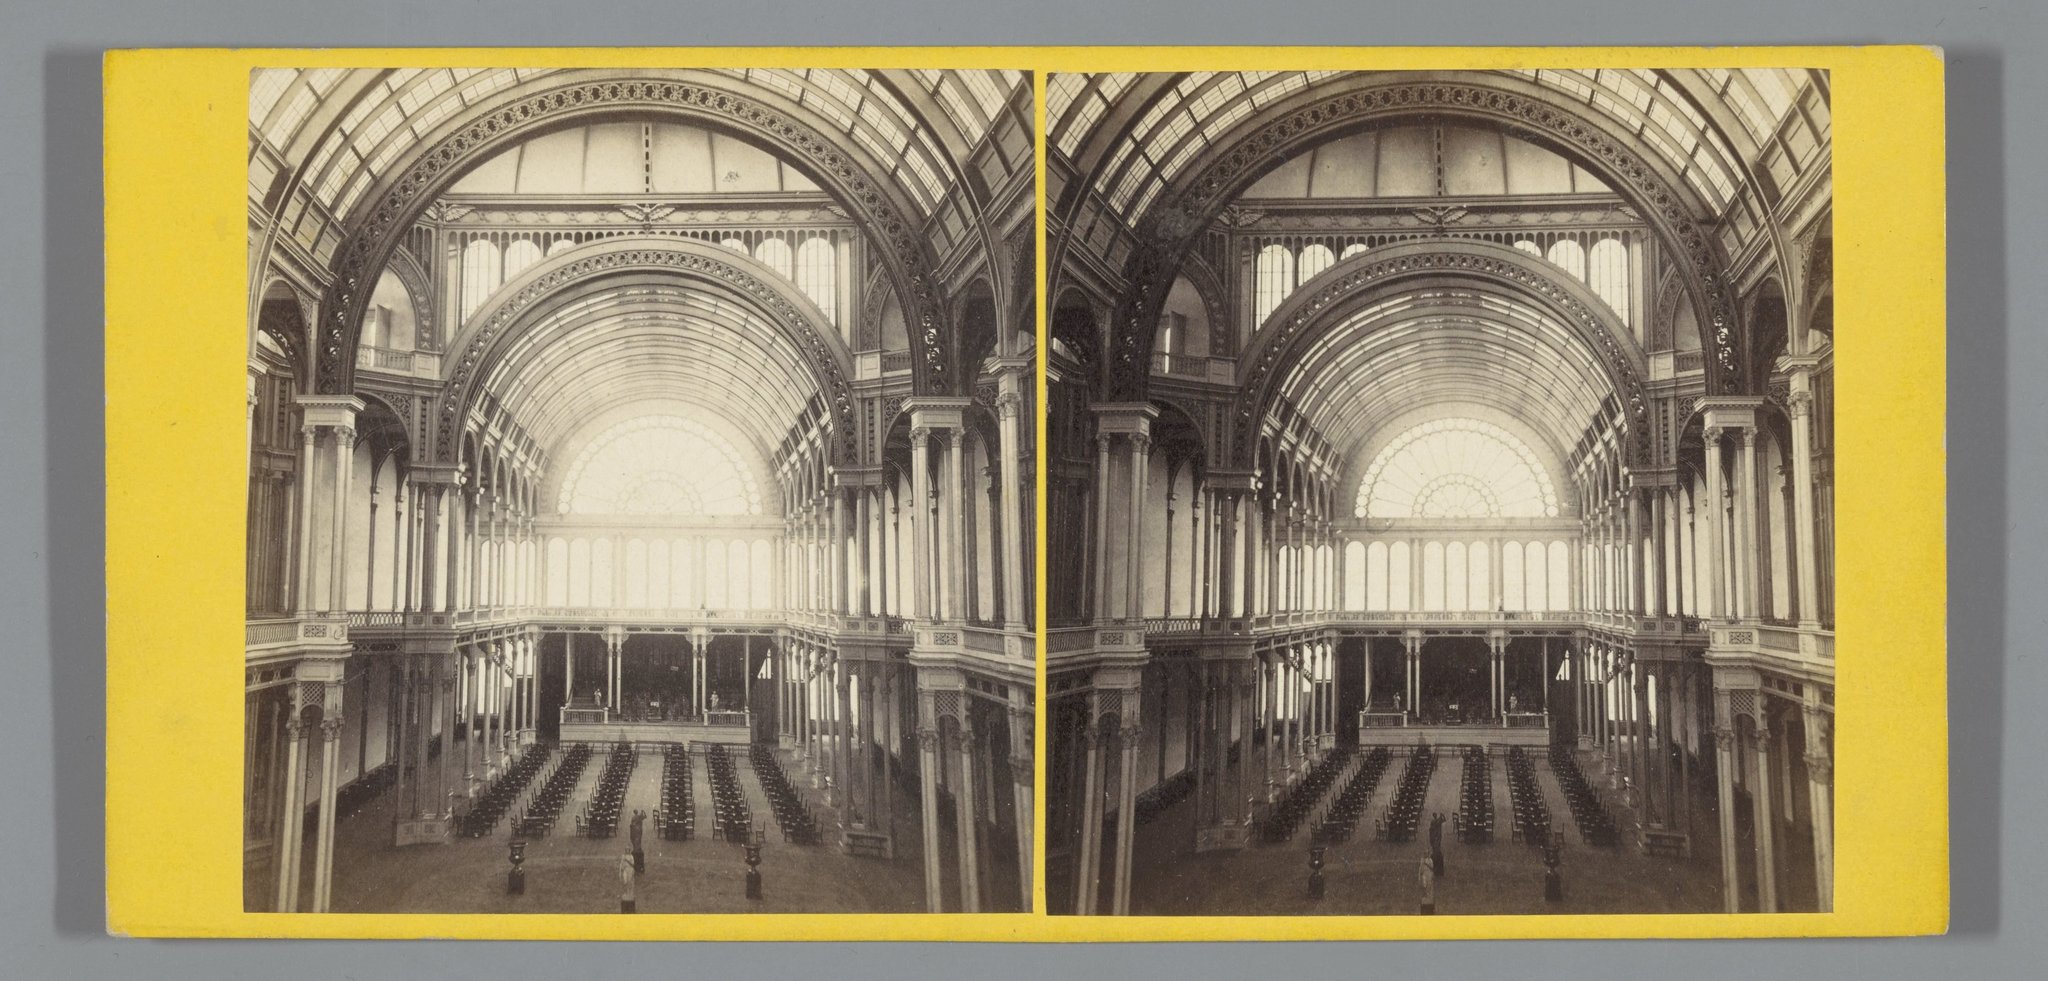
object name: stereograph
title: Gezicht op het interieur van het Paleis voor Volksvlijt in Amsterdam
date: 1860-1885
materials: cardboard, photographic support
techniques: albumen print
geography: paleis voor volksvlijt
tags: palace - aa - civic architecture: inside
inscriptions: name: ‘J. C. MEERBURG.’, inscription: ‘Stereoscopische Gezigten in Nederland./ Verkrijgbaar bij A. JAGER, Water 110, te Amsterdam.’, annotation: ‘Paleis voor Volksvlijt./ Amsterdam.’